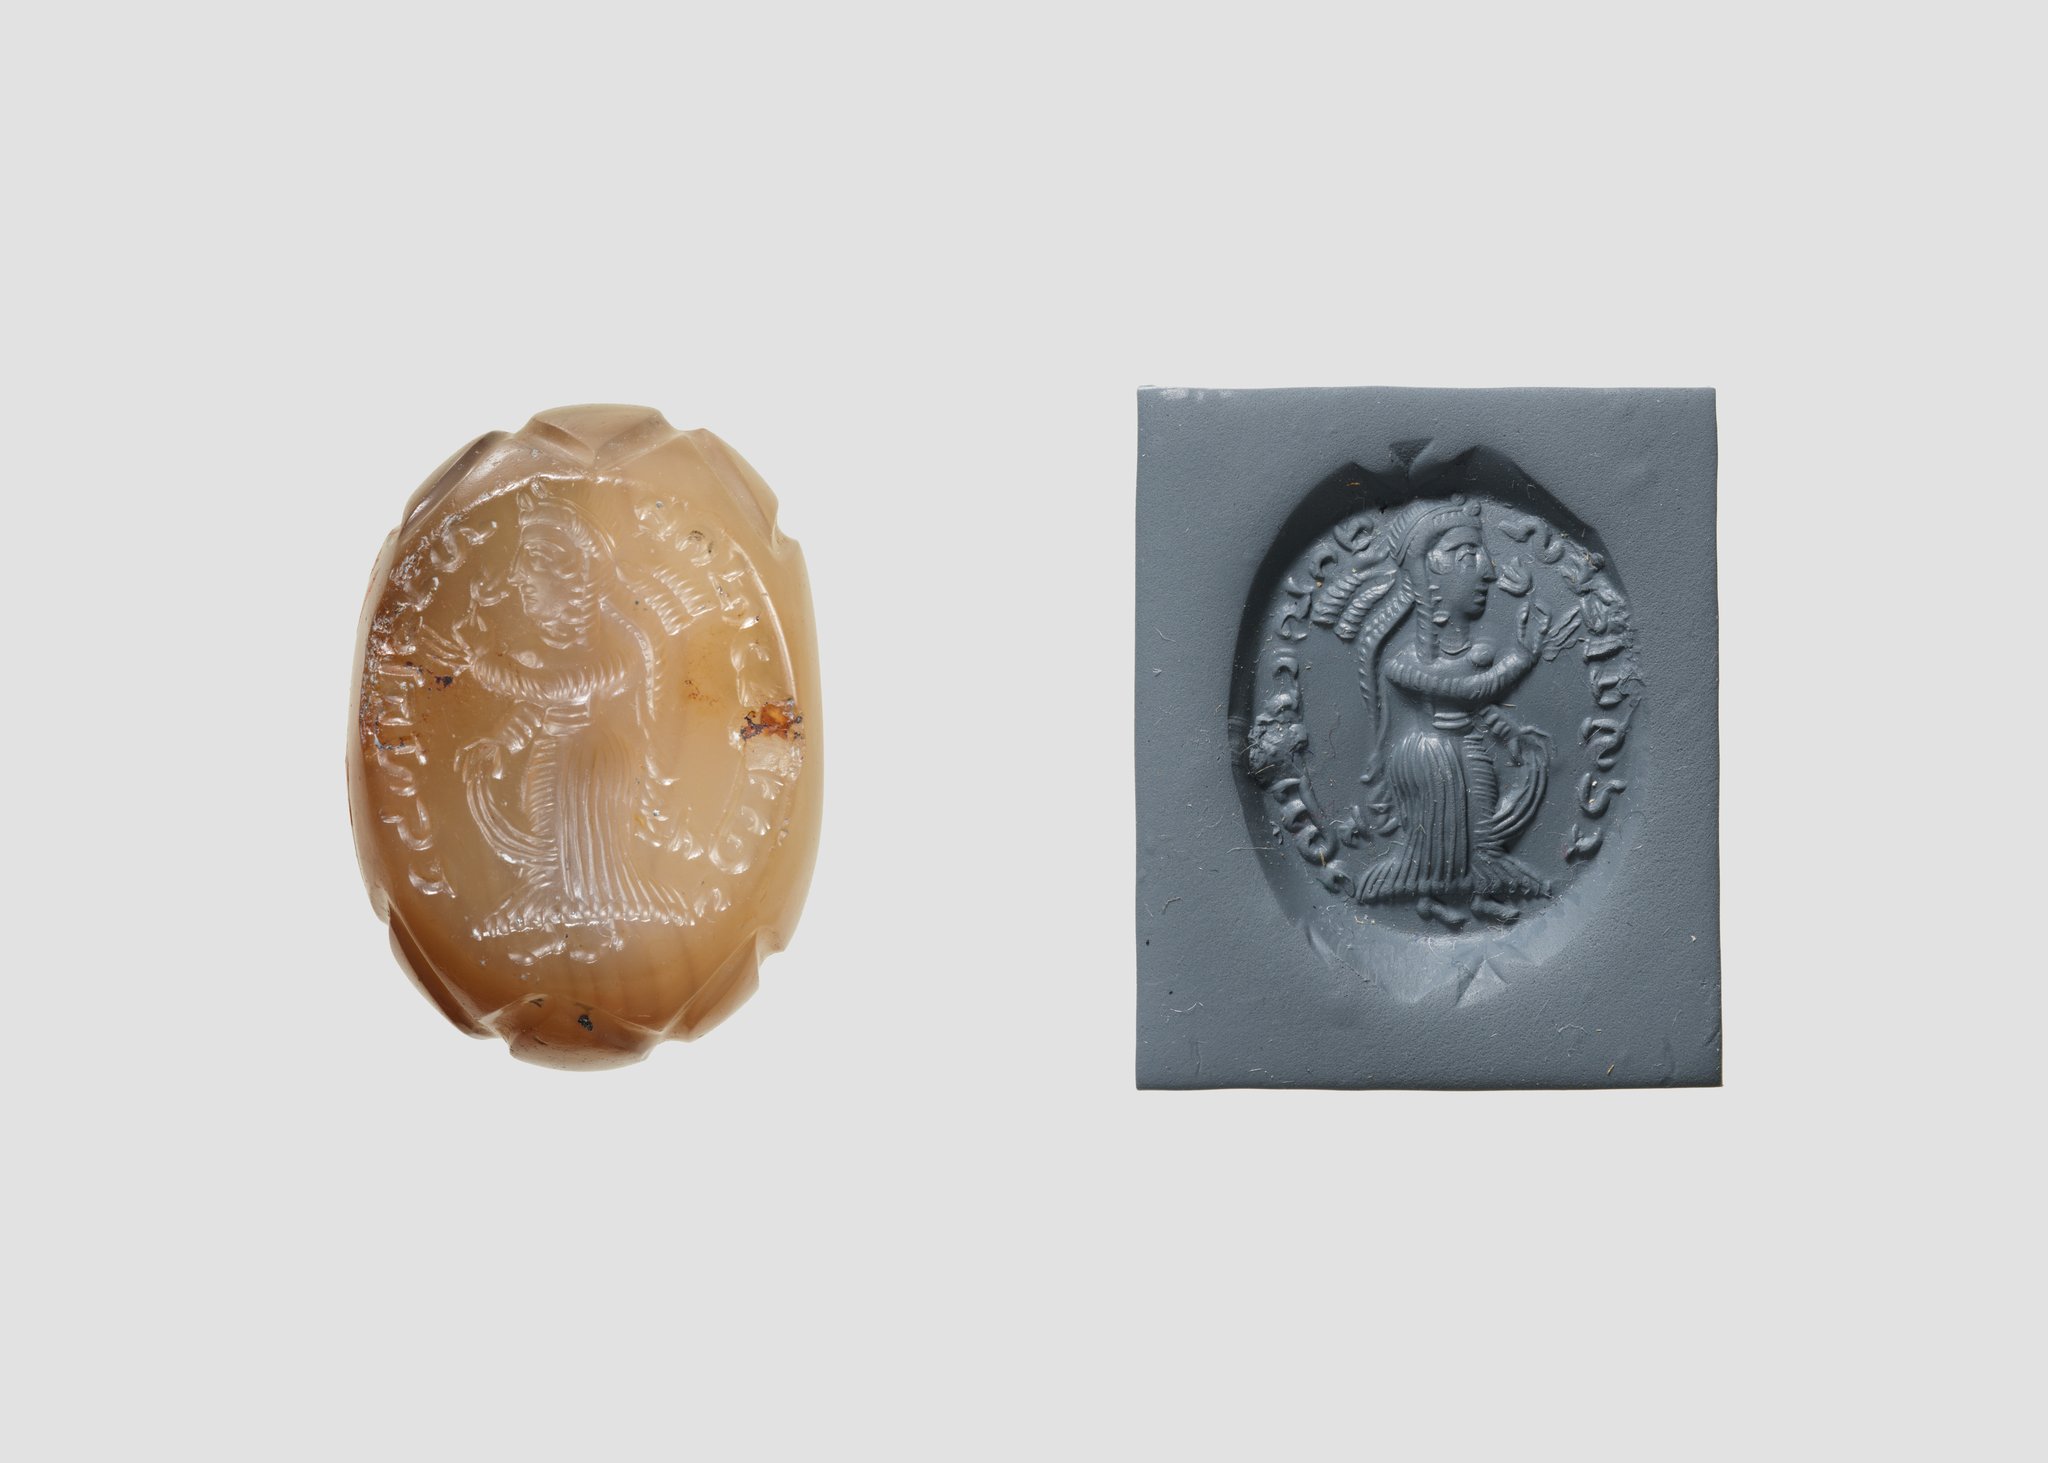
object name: stamp seal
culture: sasanian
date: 301-400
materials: stone, quartz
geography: iran